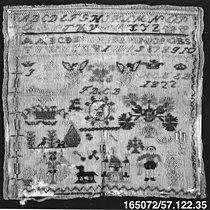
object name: sampler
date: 1822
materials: canvas, silk, wool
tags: animals